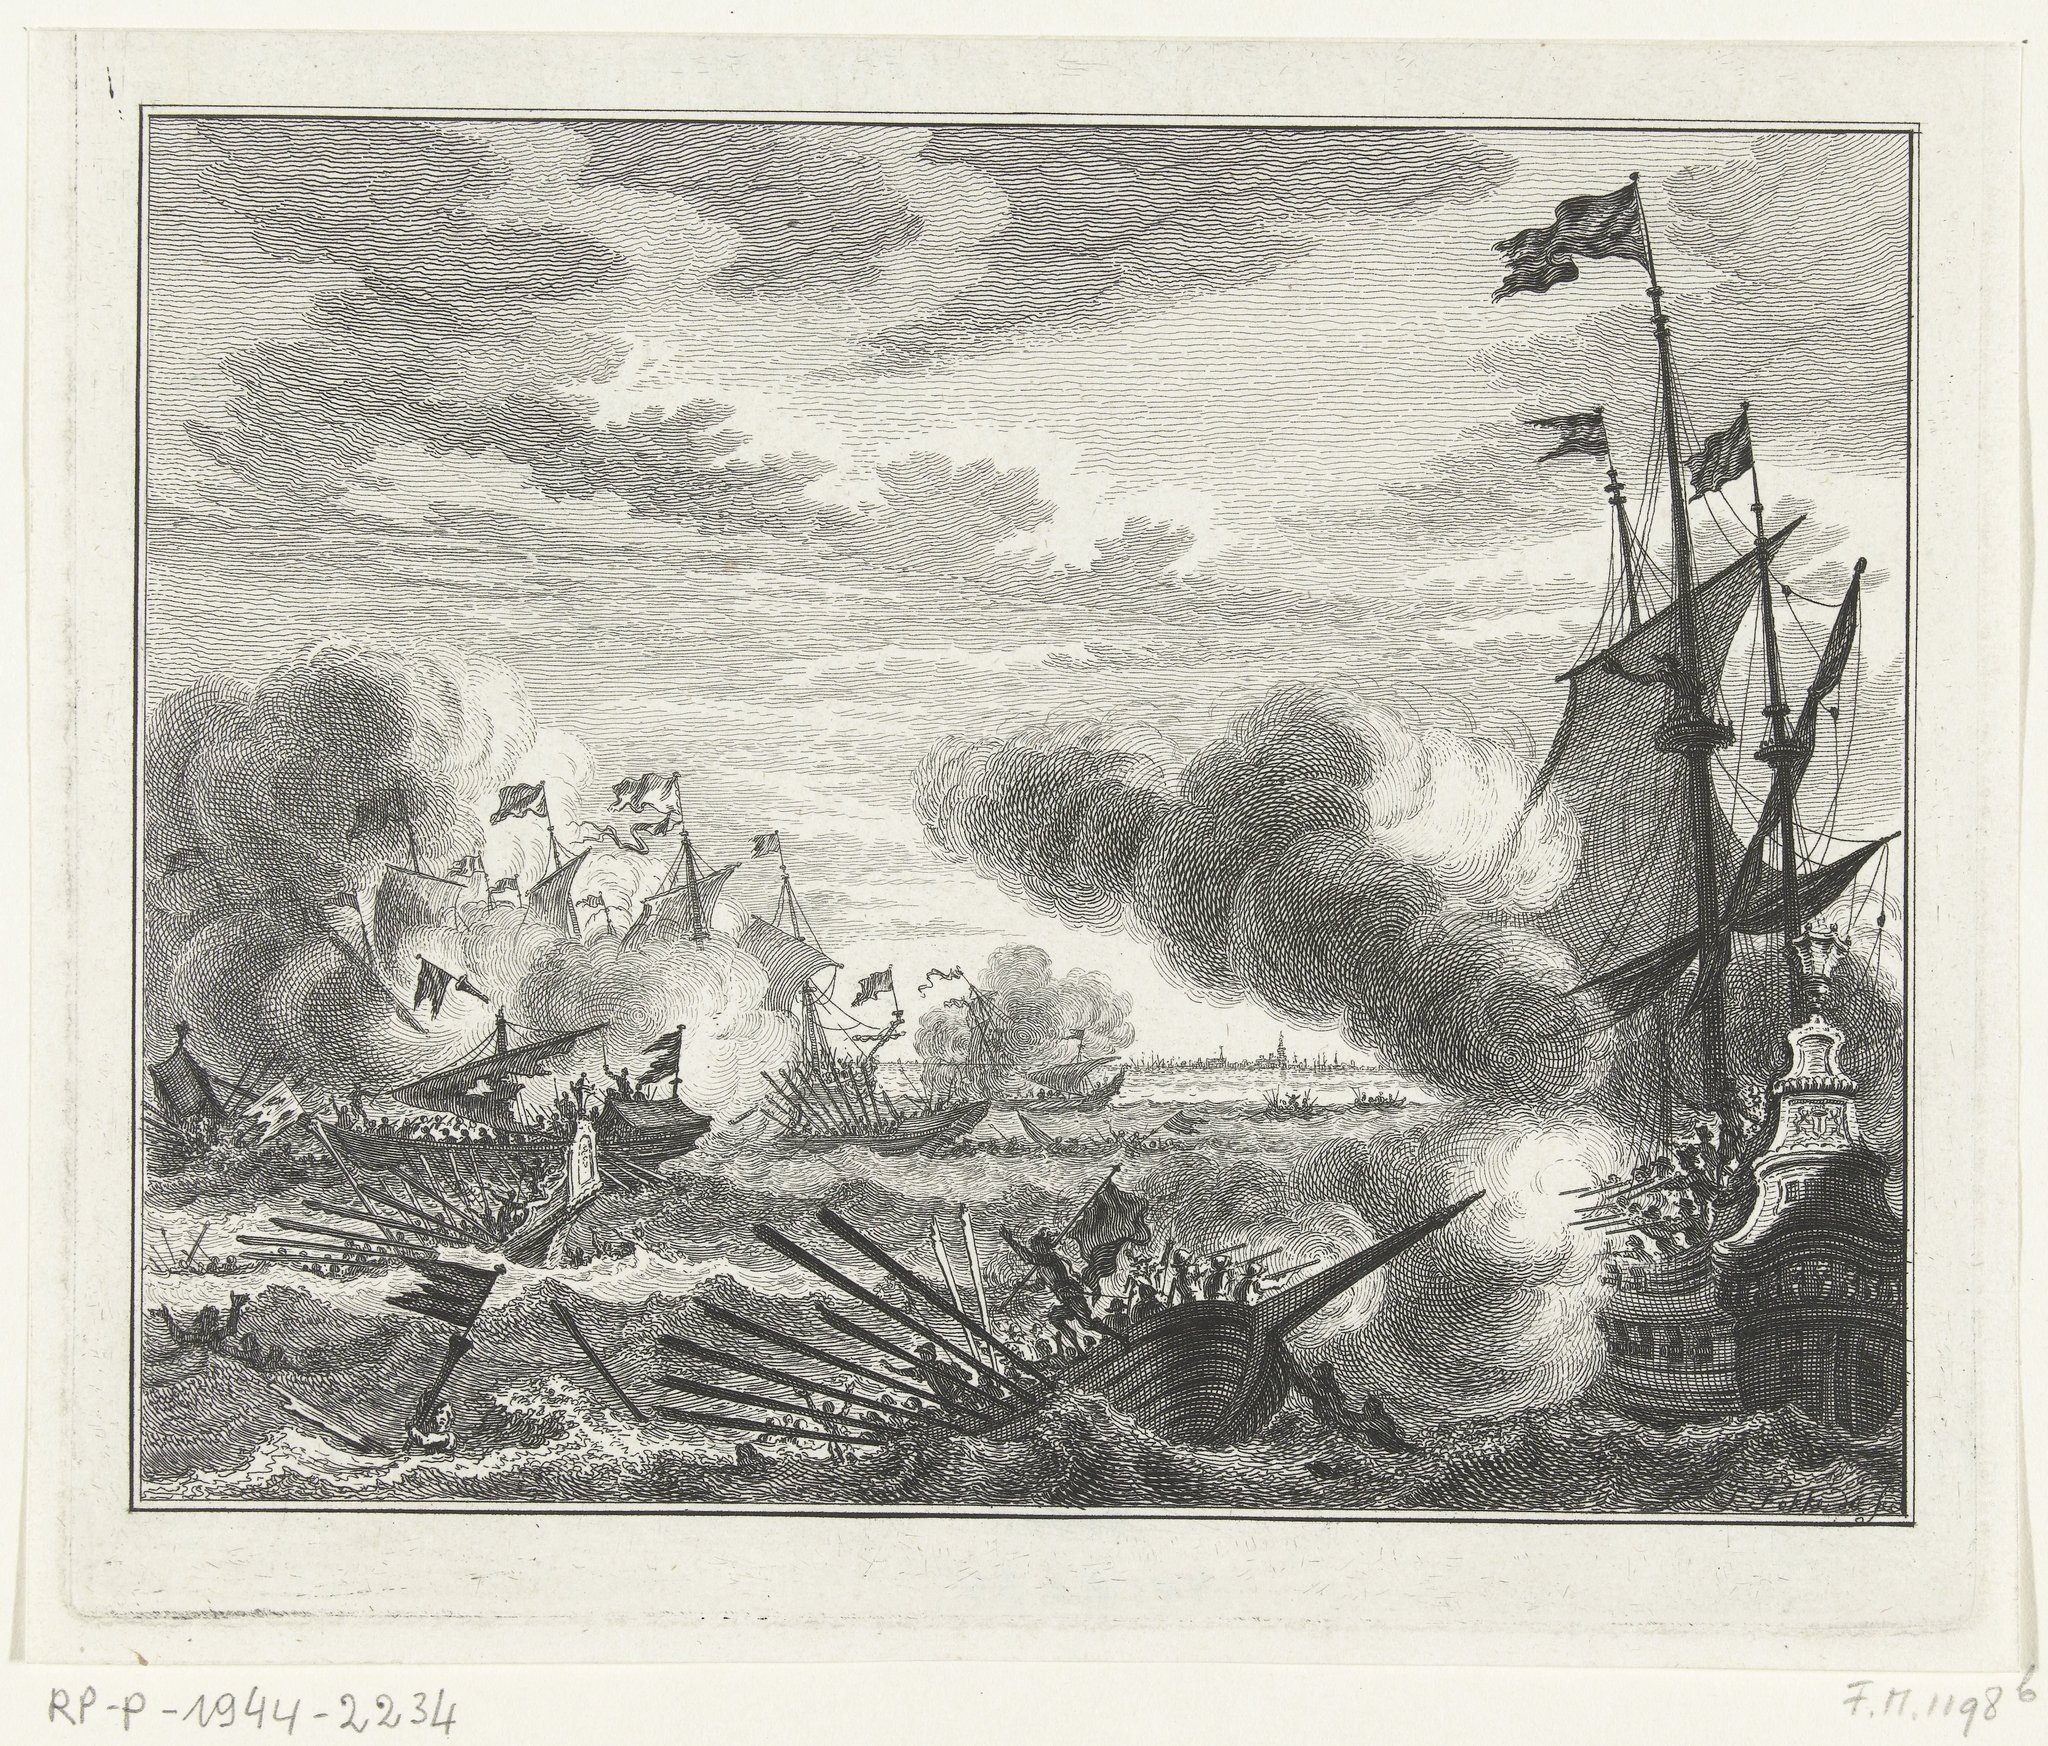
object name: print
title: De vernietiging van de Spaanse galeien voor de Vlaamse kust, 1602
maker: simon fokke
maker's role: draughtsman, print maker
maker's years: 1712-1784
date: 1756-1758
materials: paper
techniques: etching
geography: northern netherlands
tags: battle (+ naval force), warfare; military affairs (+ oared ships, e.g.: galley), trireme, galley, english channel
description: De vernietiging van de Spaanse galeien in het Kanaal voor de Vlaamse kust door de Staatse vloot onder vice-admiraal Jacob van Duivenvoorde, heer van Obdam, 3 oktober 1602. Op de voorgrond wordt een galei onder vuur genomen door een Hollands schip.